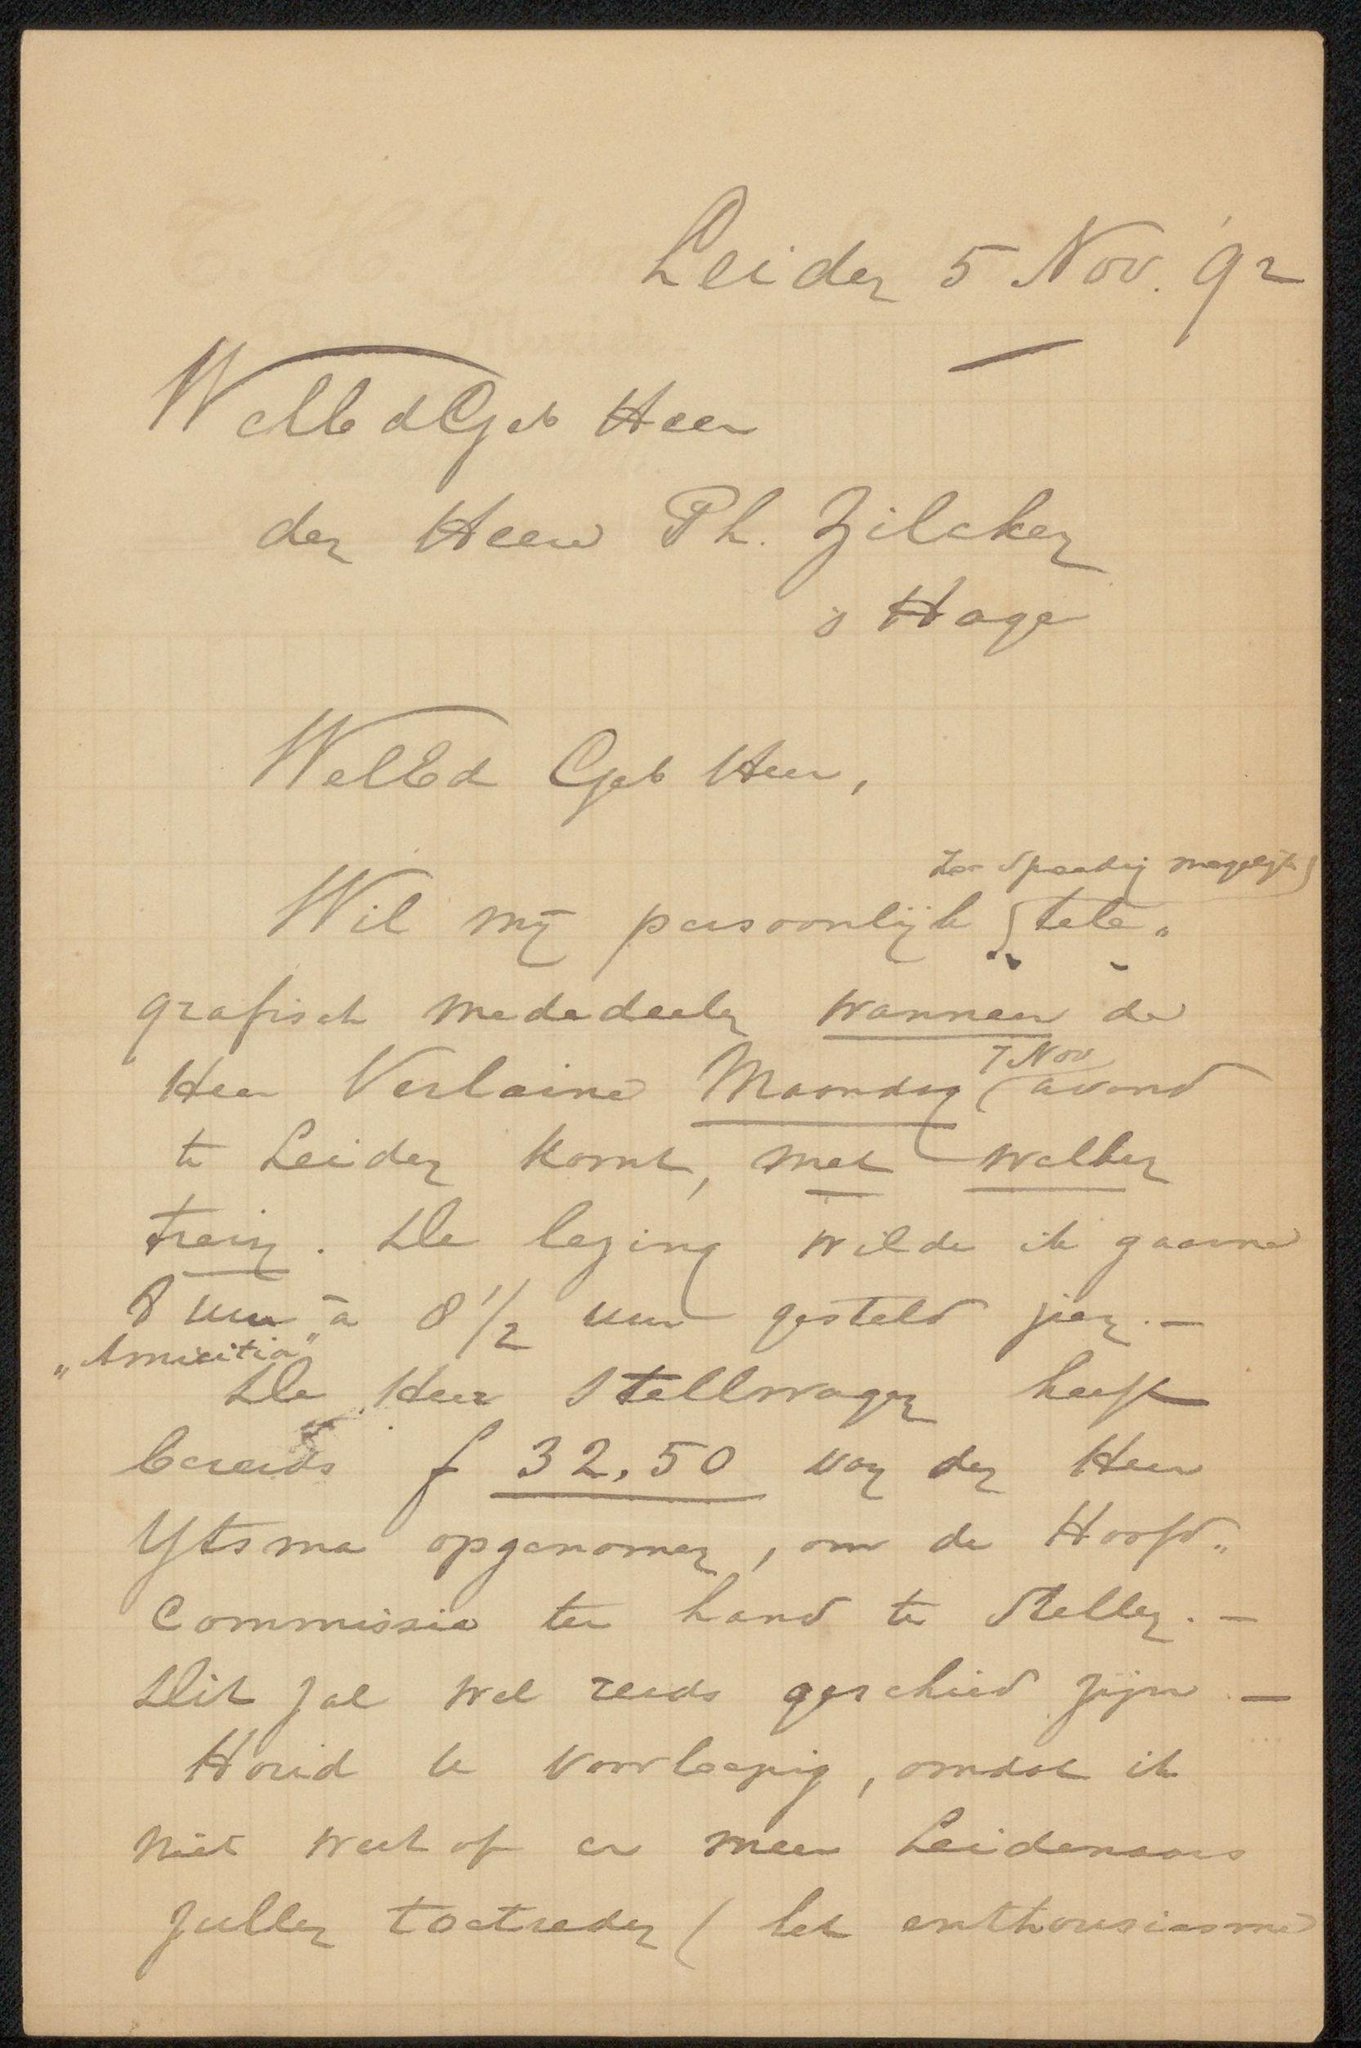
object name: letter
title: Brief aan Philip Zilcken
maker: cornelis willem hendrik verster van wulverhorst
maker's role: print maker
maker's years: 1862-1920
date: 1892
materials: ink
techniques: pen, writing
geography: leiden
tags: the hague, painter, draughtsman, jan toorop, paris, paul verlaine, engineer, gerard johan staal, philip zilcken, criticizing and discussing art, art criticism, money, leiden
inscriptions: watermark, collector's mark: ‘RPK’